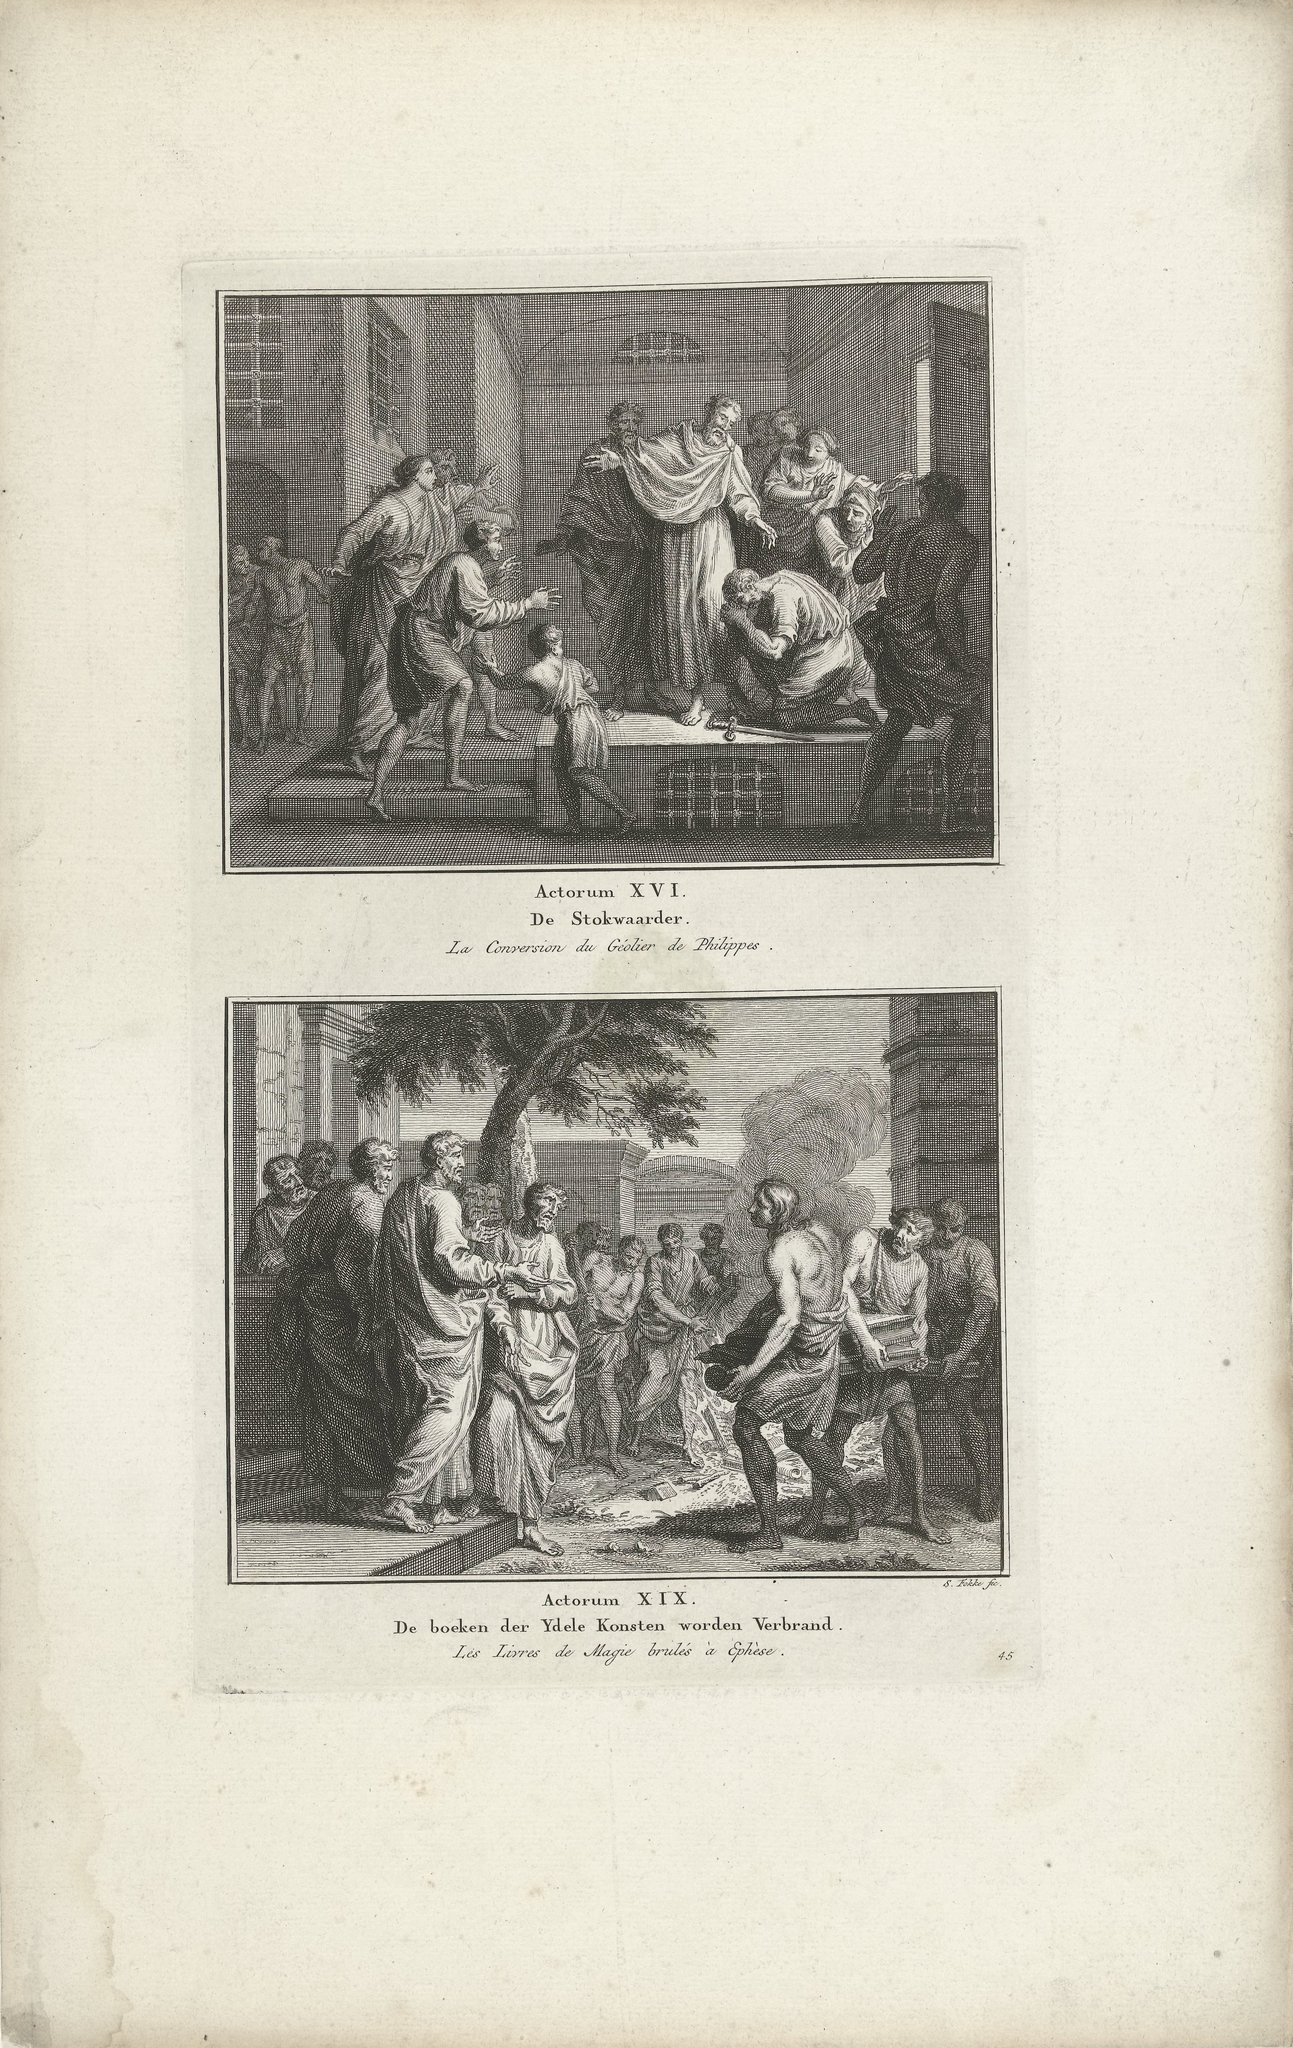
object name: print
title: Bekering van de stokbewaarder en Magische boeken te Ephese verbrand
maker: simon fokke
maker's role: draughtsman, print maker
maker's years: 1712-1784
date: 1791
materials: paper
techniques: etching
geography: amsterdam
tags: the ephesians burn the exorcists' books in public, paul and silas teach the word of god to the warder, who kneels before them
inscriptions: collector's mark: Lugt 2233, collector's mark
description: Twee Bijbelse voorstellingen uit Hand. 16 en 19. Genummerd rechtsonder: 45.